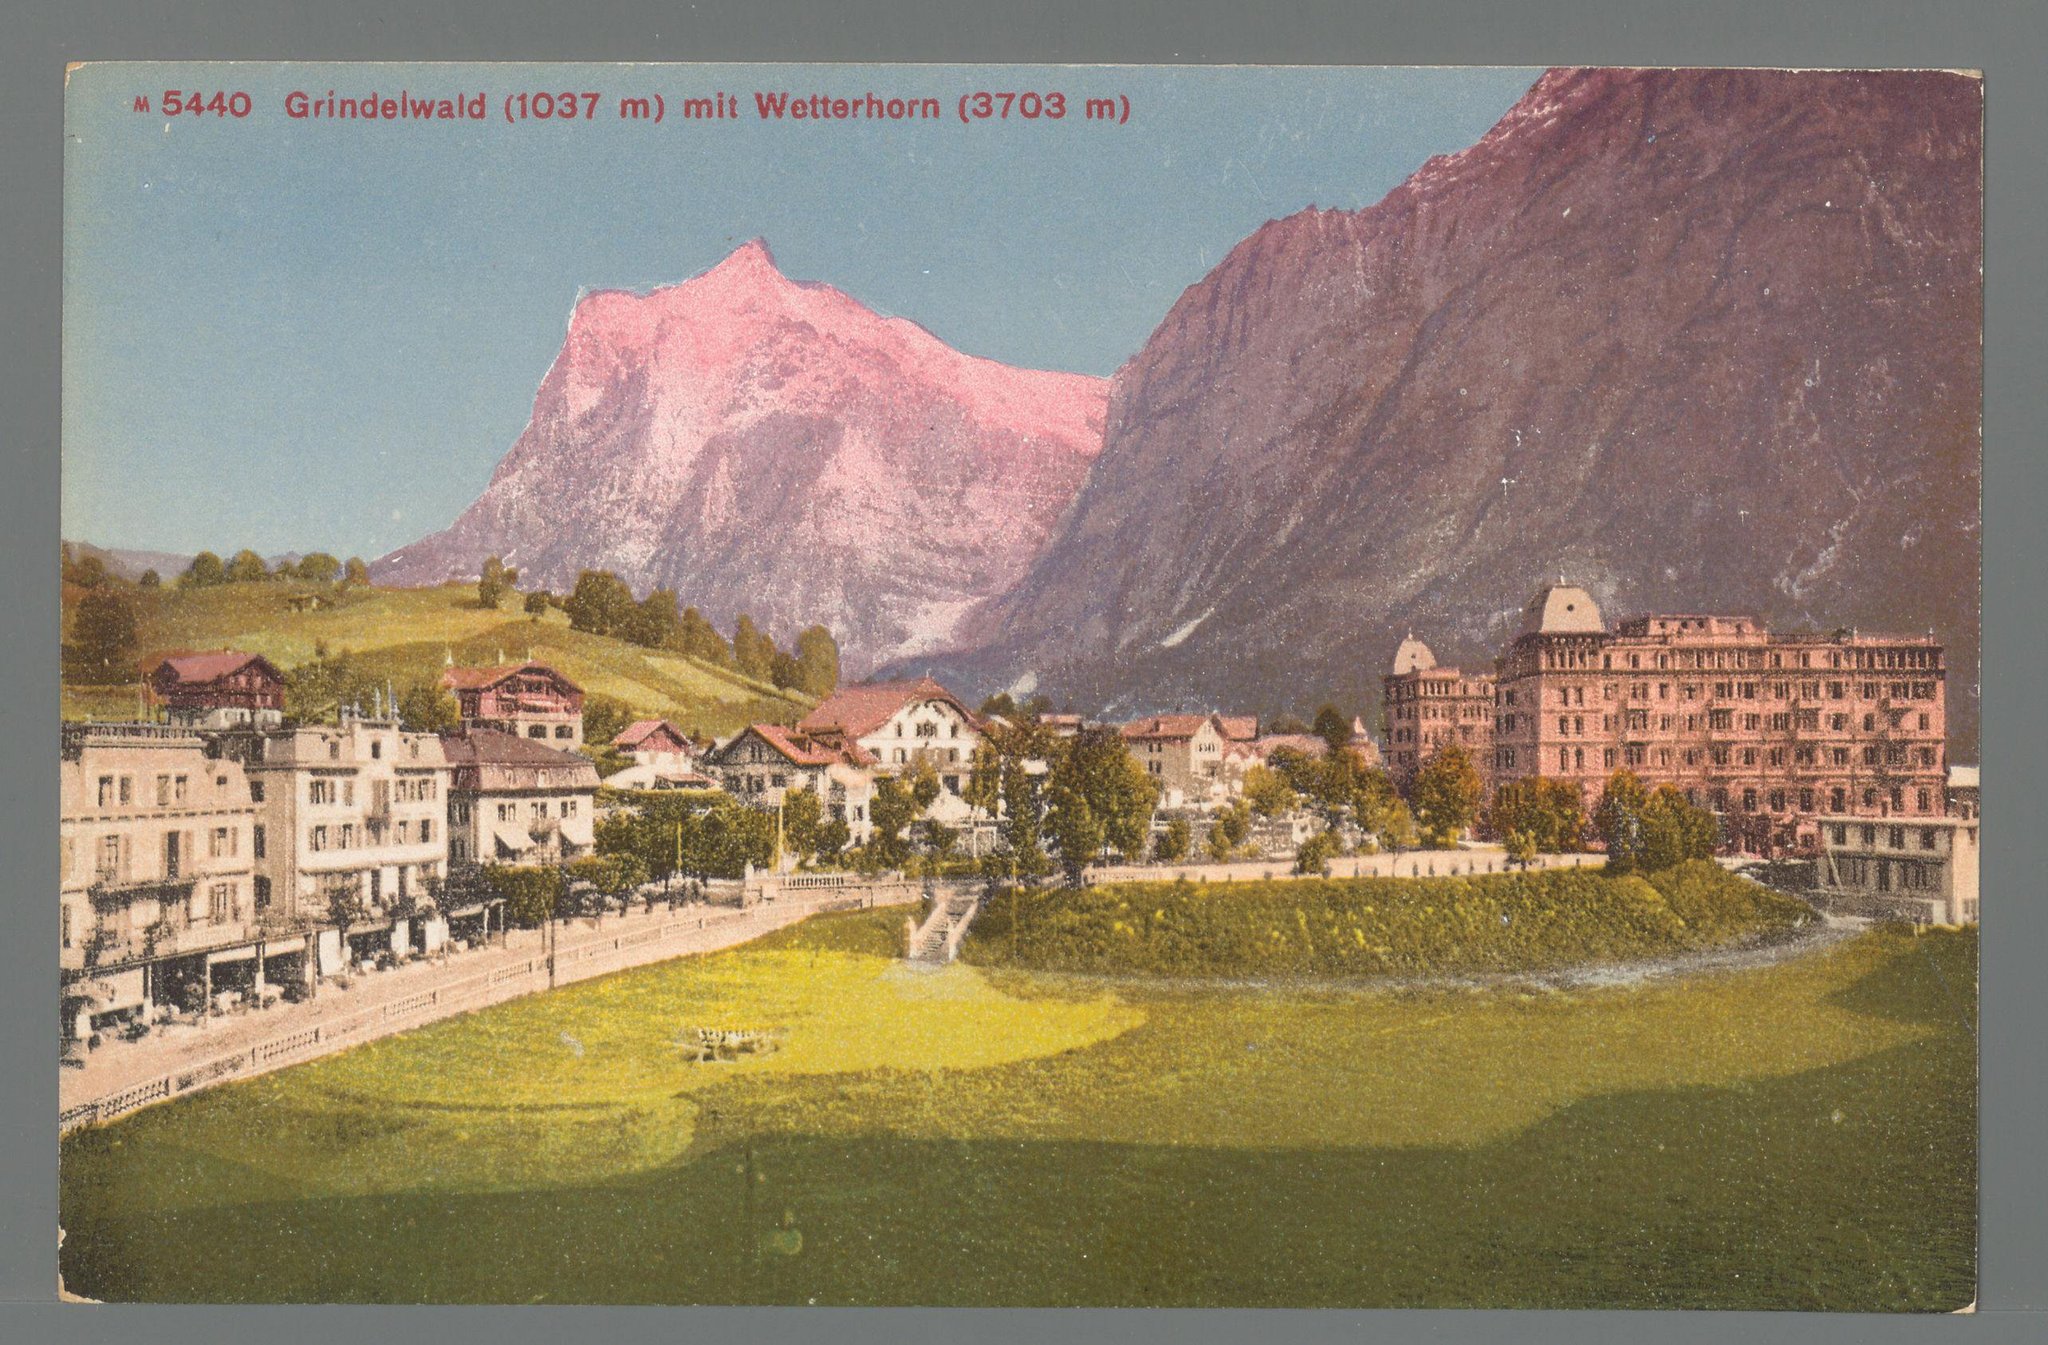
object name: photomechanical print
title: Grindelwald (1037 m) mit Wetterhorn (3703 m)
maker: Anonymous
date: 1905-1930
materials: cardboard, photographic process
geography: grindelwald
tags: prospect of village, silhouette of village, dale, valley, mountain-range, snow peaks